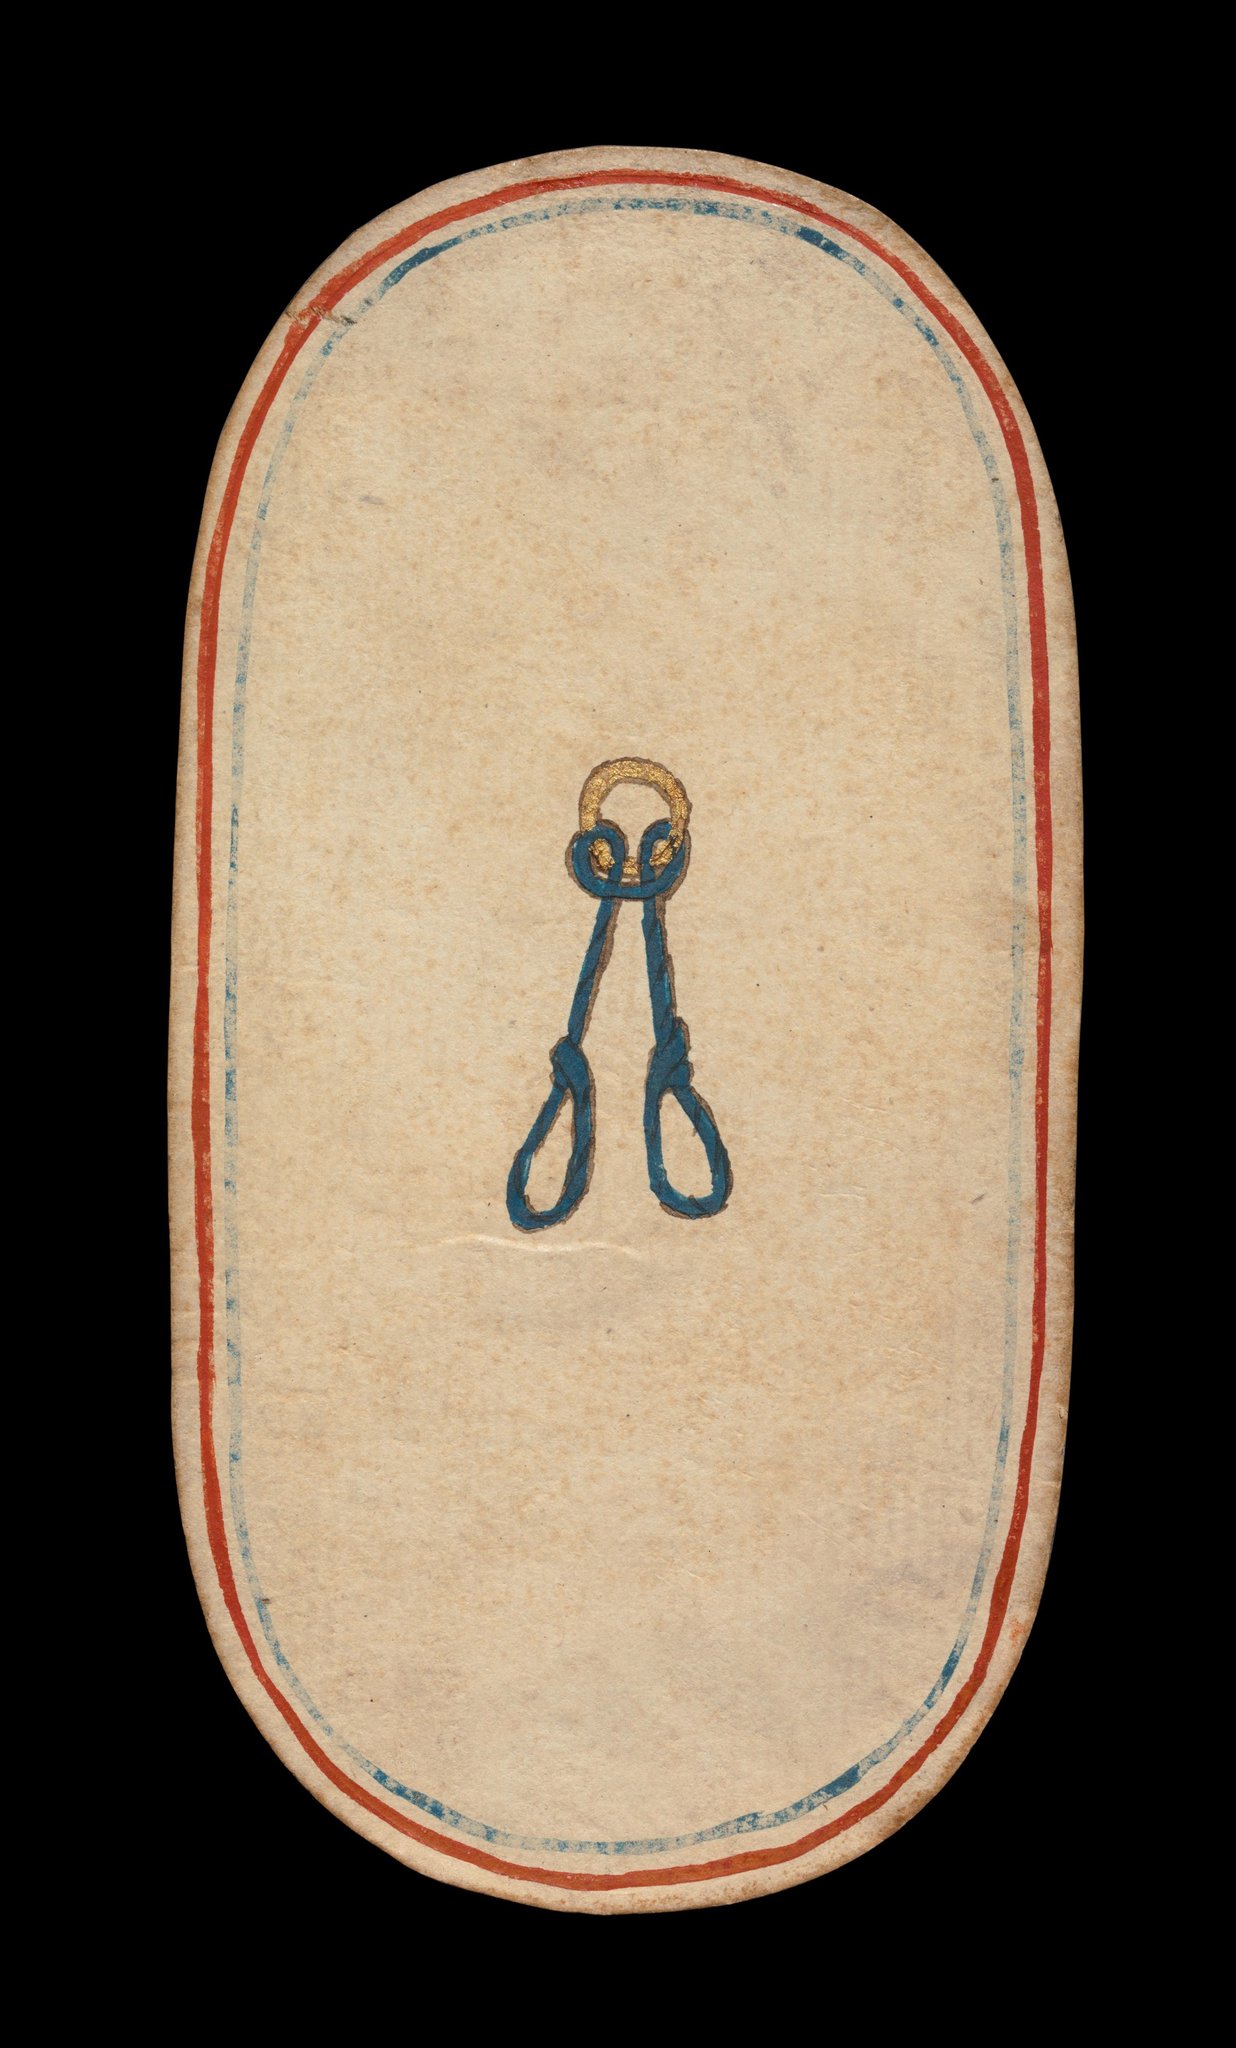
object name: playing card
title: 1 of Nooses, from The Cloisters Playing Cards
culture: south netherlandish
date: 1475-1480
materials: glaze, gold, ink, paint, paper, silver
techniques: pen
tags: playing cards,games